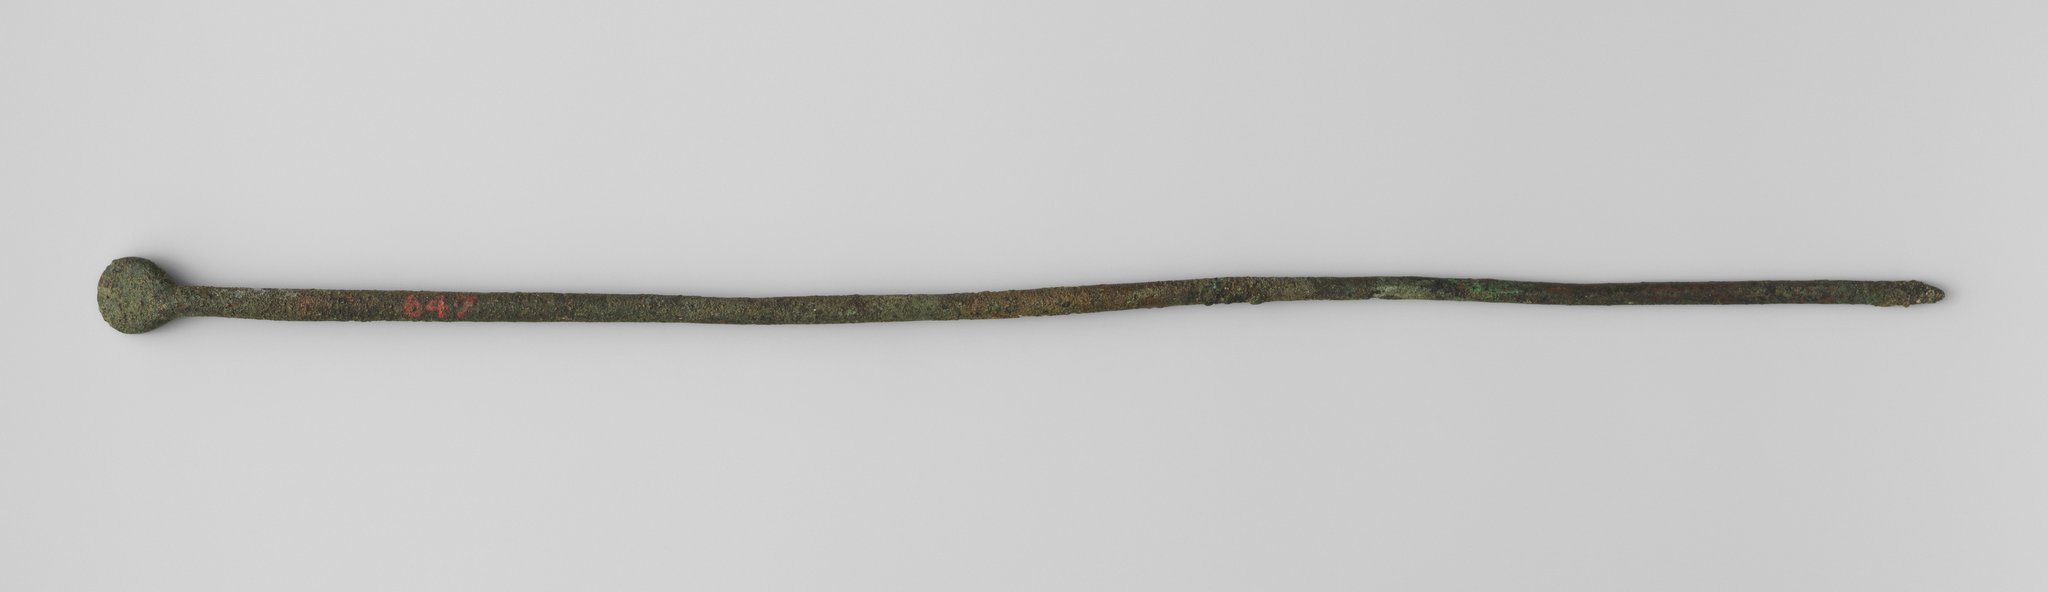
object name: tool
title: Implement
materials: copper alloy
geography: egypt